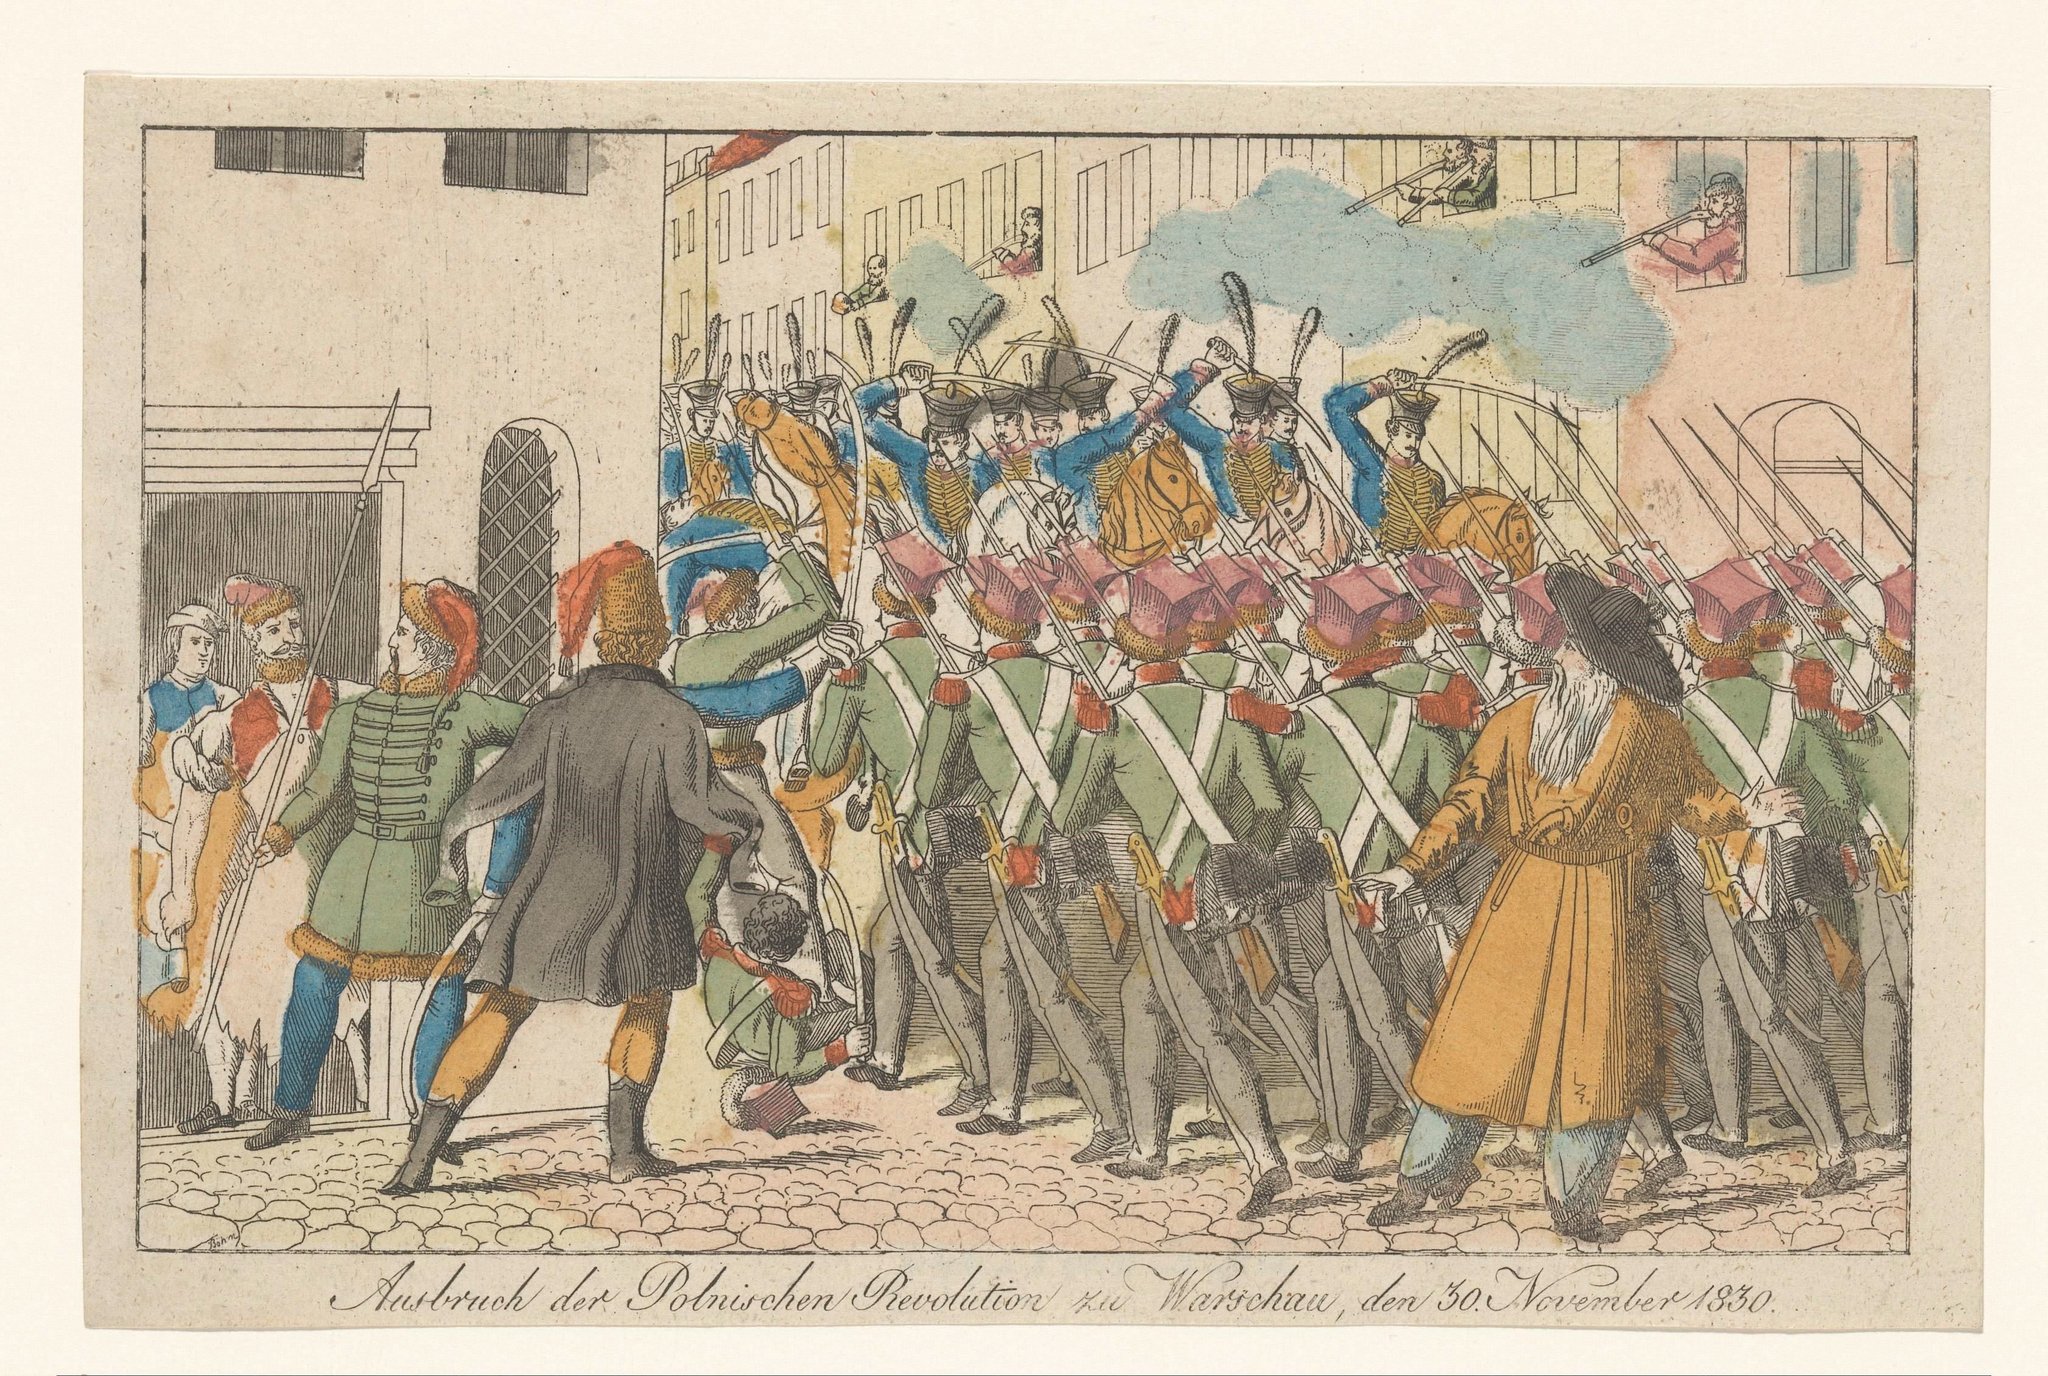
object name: print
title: Ausbruch der Polnischen Revolution zu Warschau, den 30. November 1830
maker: Anonymous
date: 1830-1831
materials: paper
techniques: etching, hand coloring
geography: germany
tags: street-fights, riots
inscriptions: collector's mark: Lugt 2228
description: Uitbraak van de Novemberopstand in Warschau, 30 november 1830. Kadetten van de Poolse militaire academie komen in opstand tegen de Russische troepen in de stad.